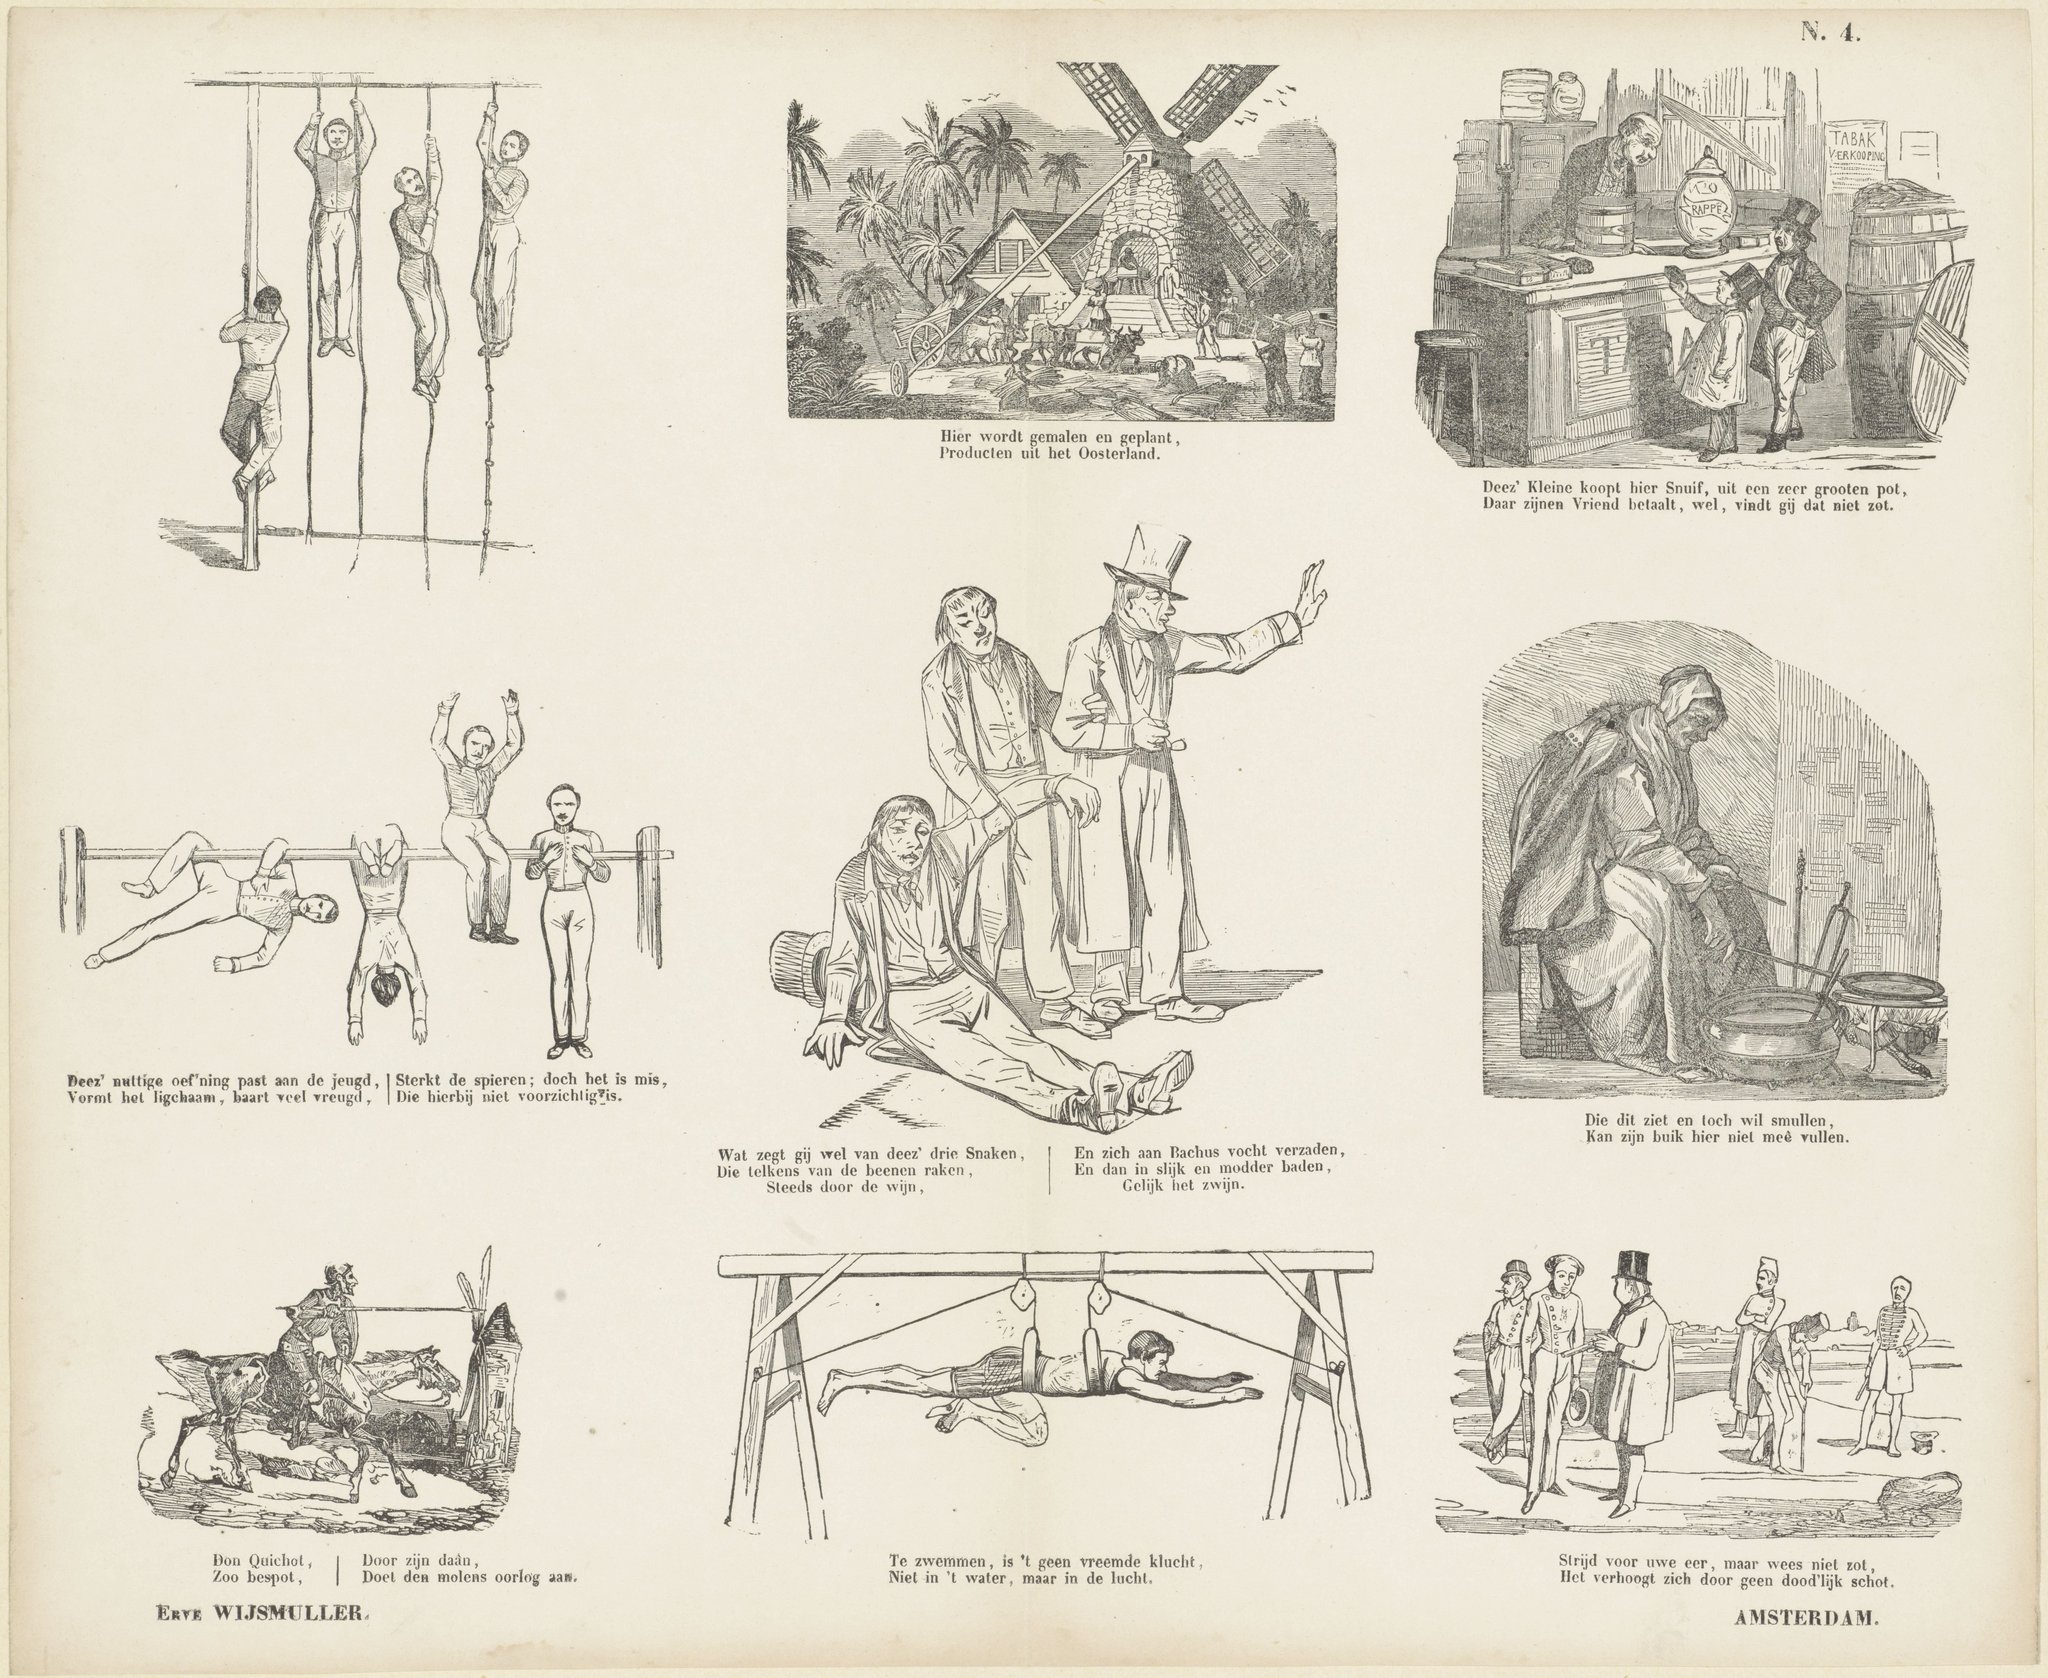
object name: popular print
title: Verschillende voorstellingen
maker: Anonymous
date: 1828-1913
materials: paper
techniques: letterpress printing, line block, engraving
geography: netherlands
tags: drunkard, drunkenness, windmill, athletics, gymnastics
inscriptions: collector's mark: Lugt 2760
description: Blad met 9 voorstellingen van verschillende aard, waaronder gymnastiekoefeningen, een molen, een tabakswinkel en dronken lieden. Onder elke afbeelding een onderschrift. Onder de eerste afbeelding het onderschrift: Hier wordt gemalen en geplant, / producten uit het Oosterland. Genummerd rechtsboven: No. 4.